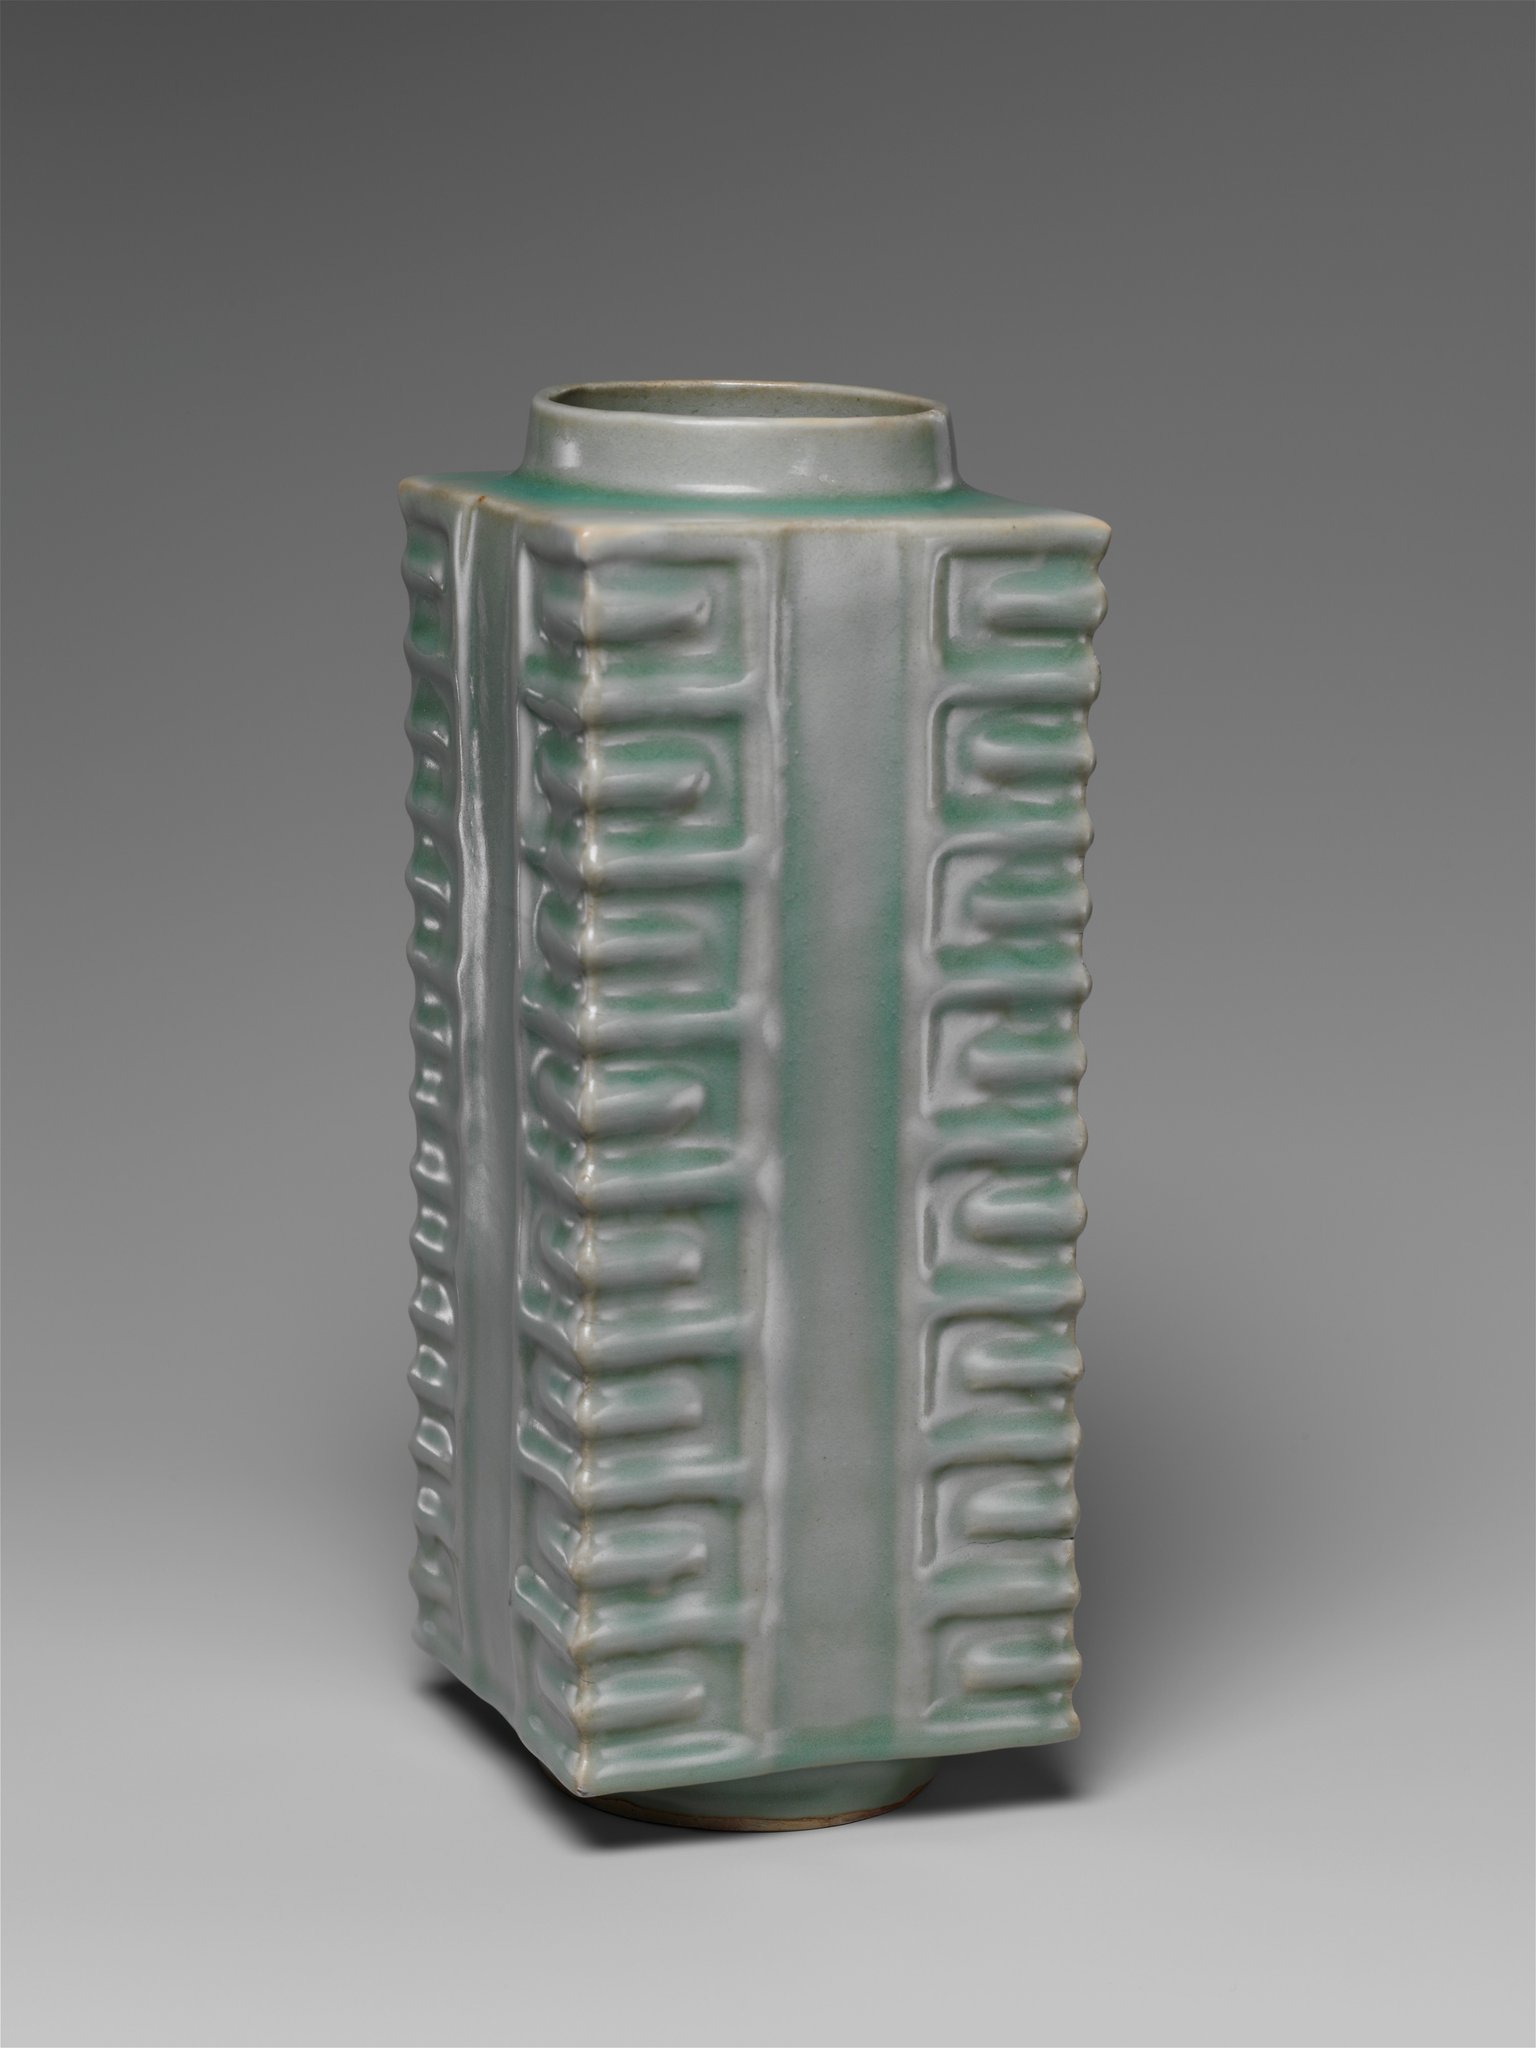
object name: cong form vase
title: Quadrangular vase in the shape of a Neolithic cong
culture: chinese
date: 1201-1300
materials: ceramic glaze, glaze, stoneware